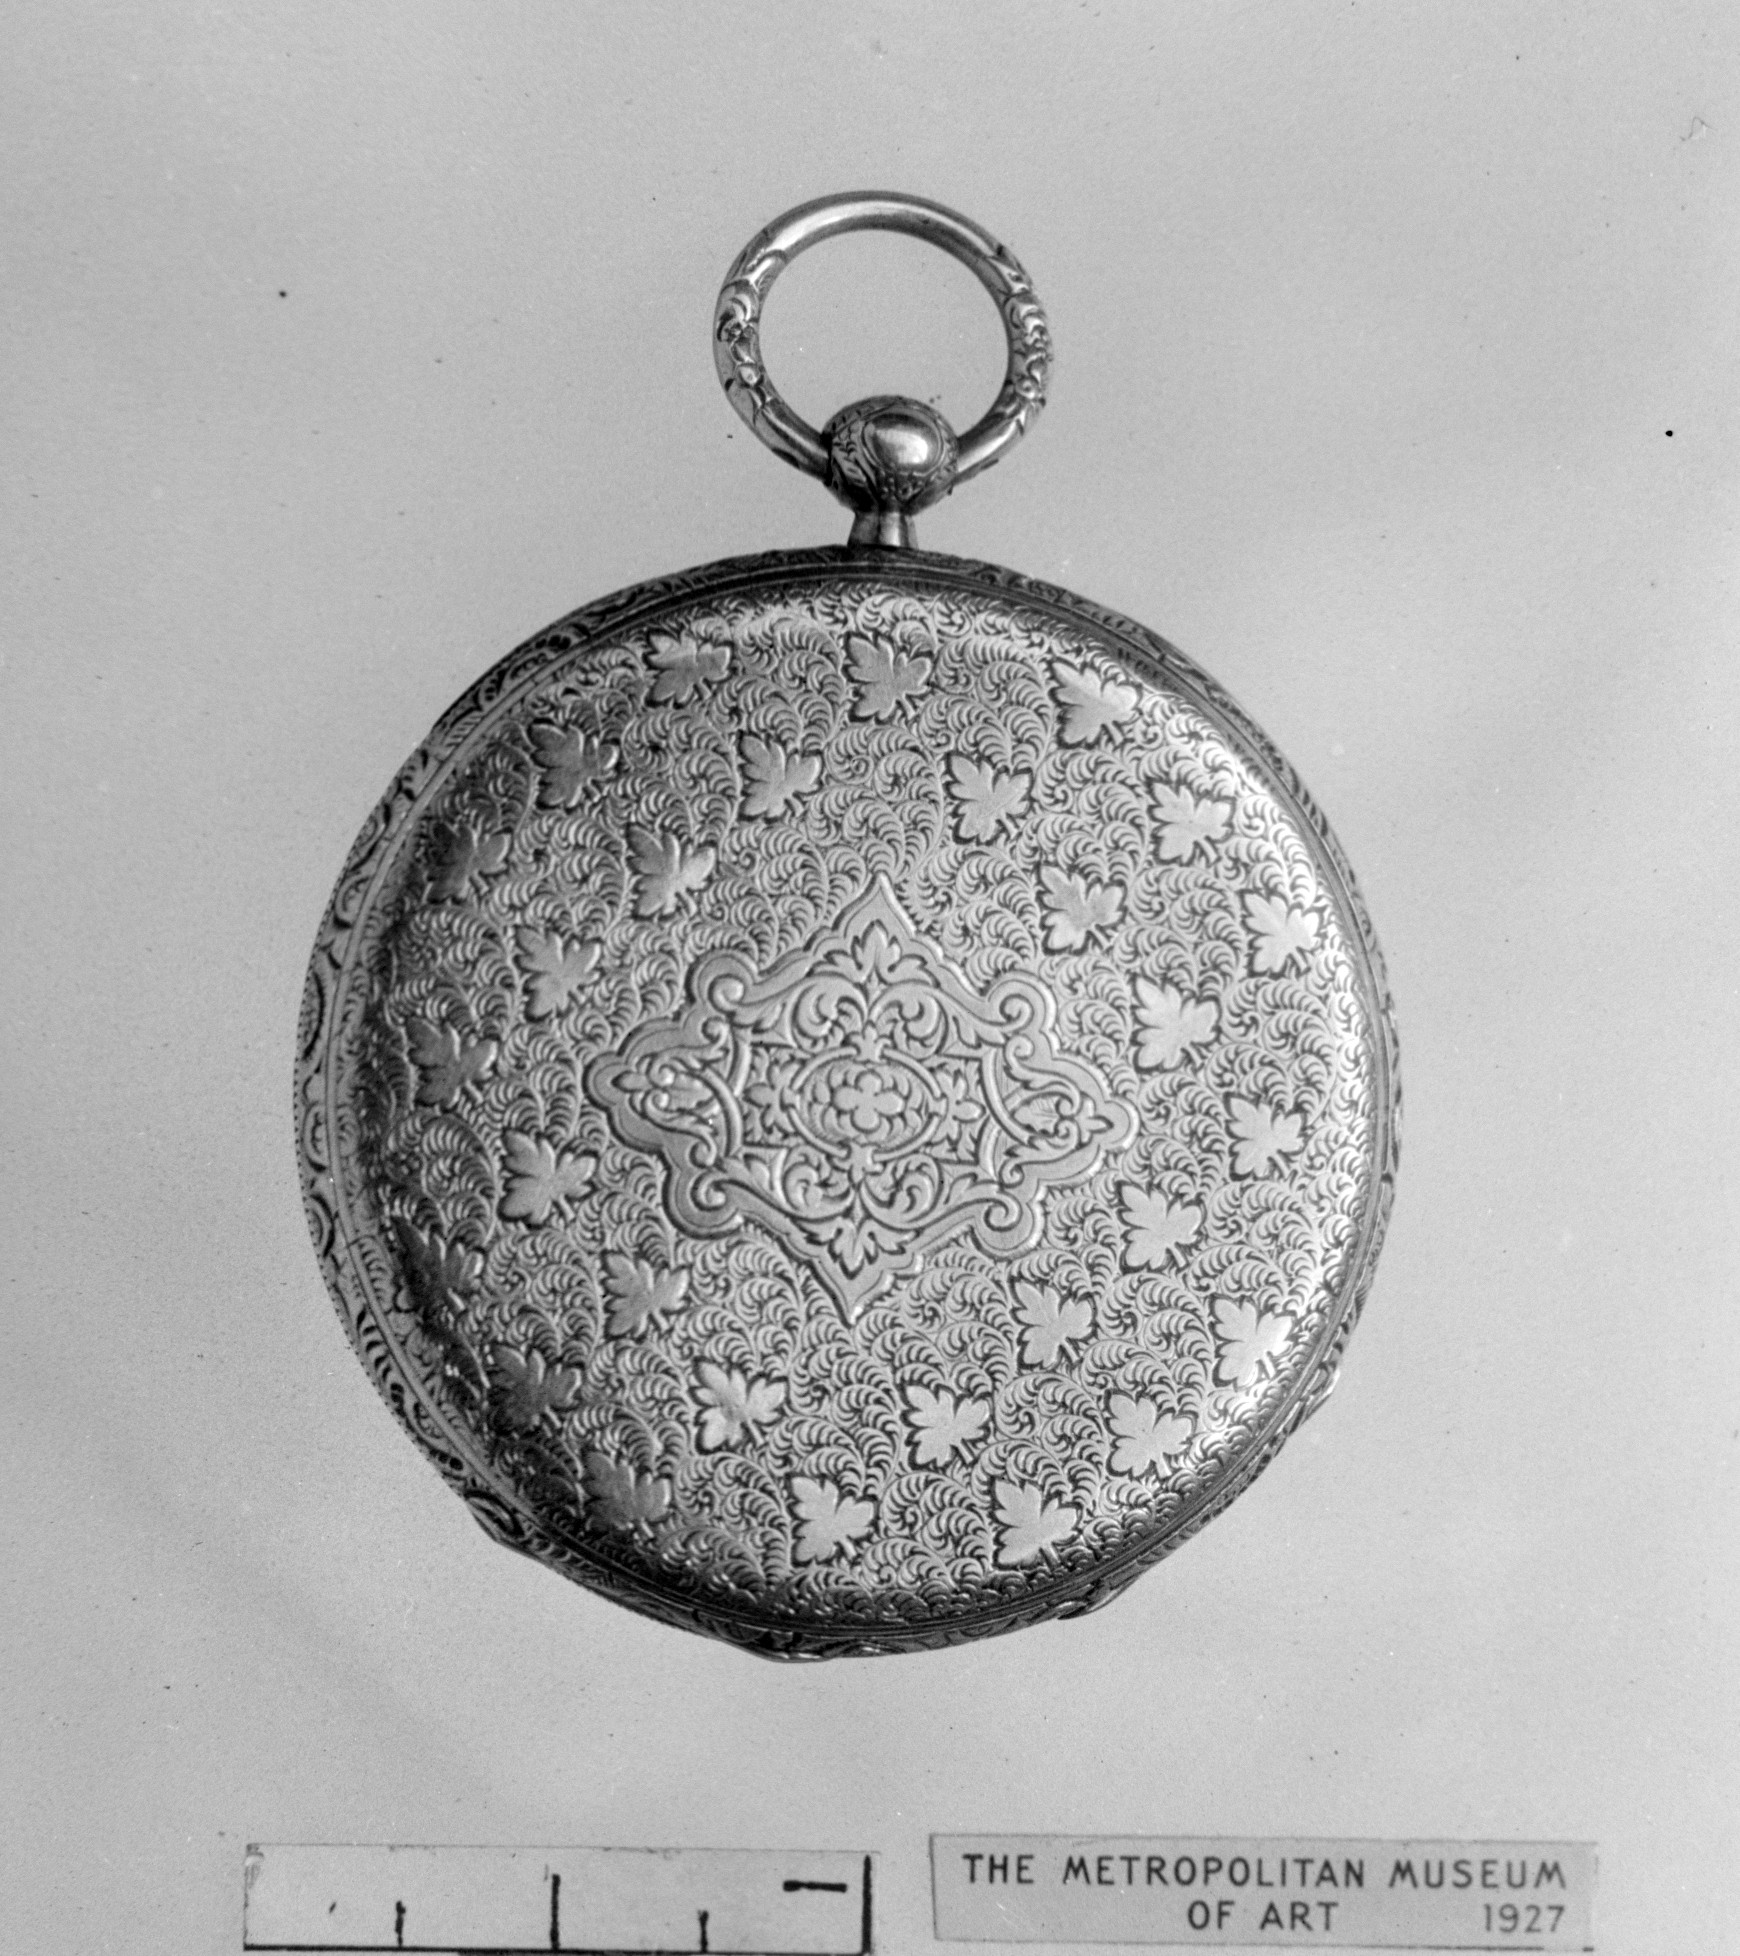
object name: watch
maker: firm of a. meynadier et cie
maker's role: maker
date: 1834-1866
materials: enamel, gold, steel